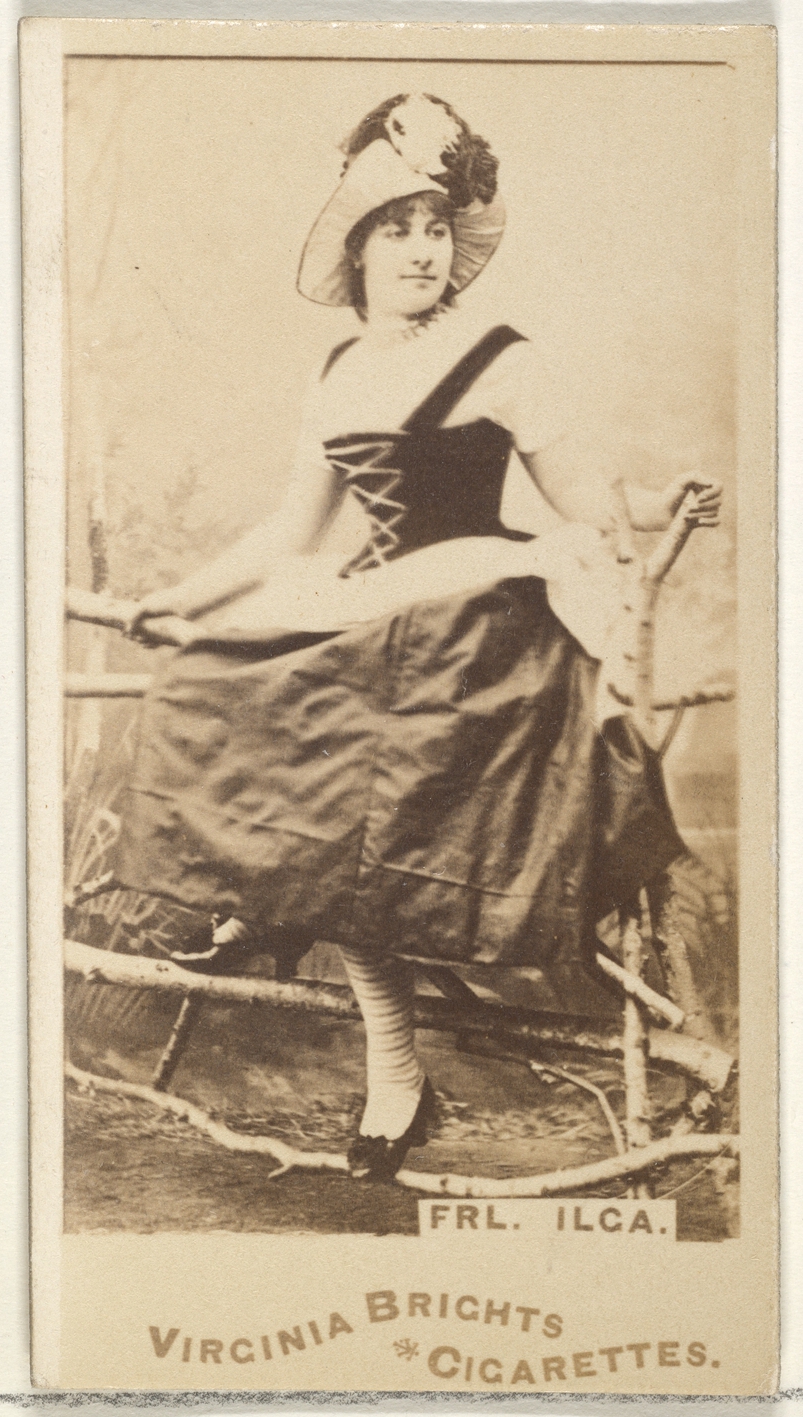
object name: photograph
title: Fräulein Ilga, from the Actors and Actresses series (N45, Type 1) for Virginia Brights Cigarettes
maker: allen & ginter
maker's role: publisher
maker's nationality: american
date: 1888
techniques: albumen silver print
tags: portraits,women,actresses